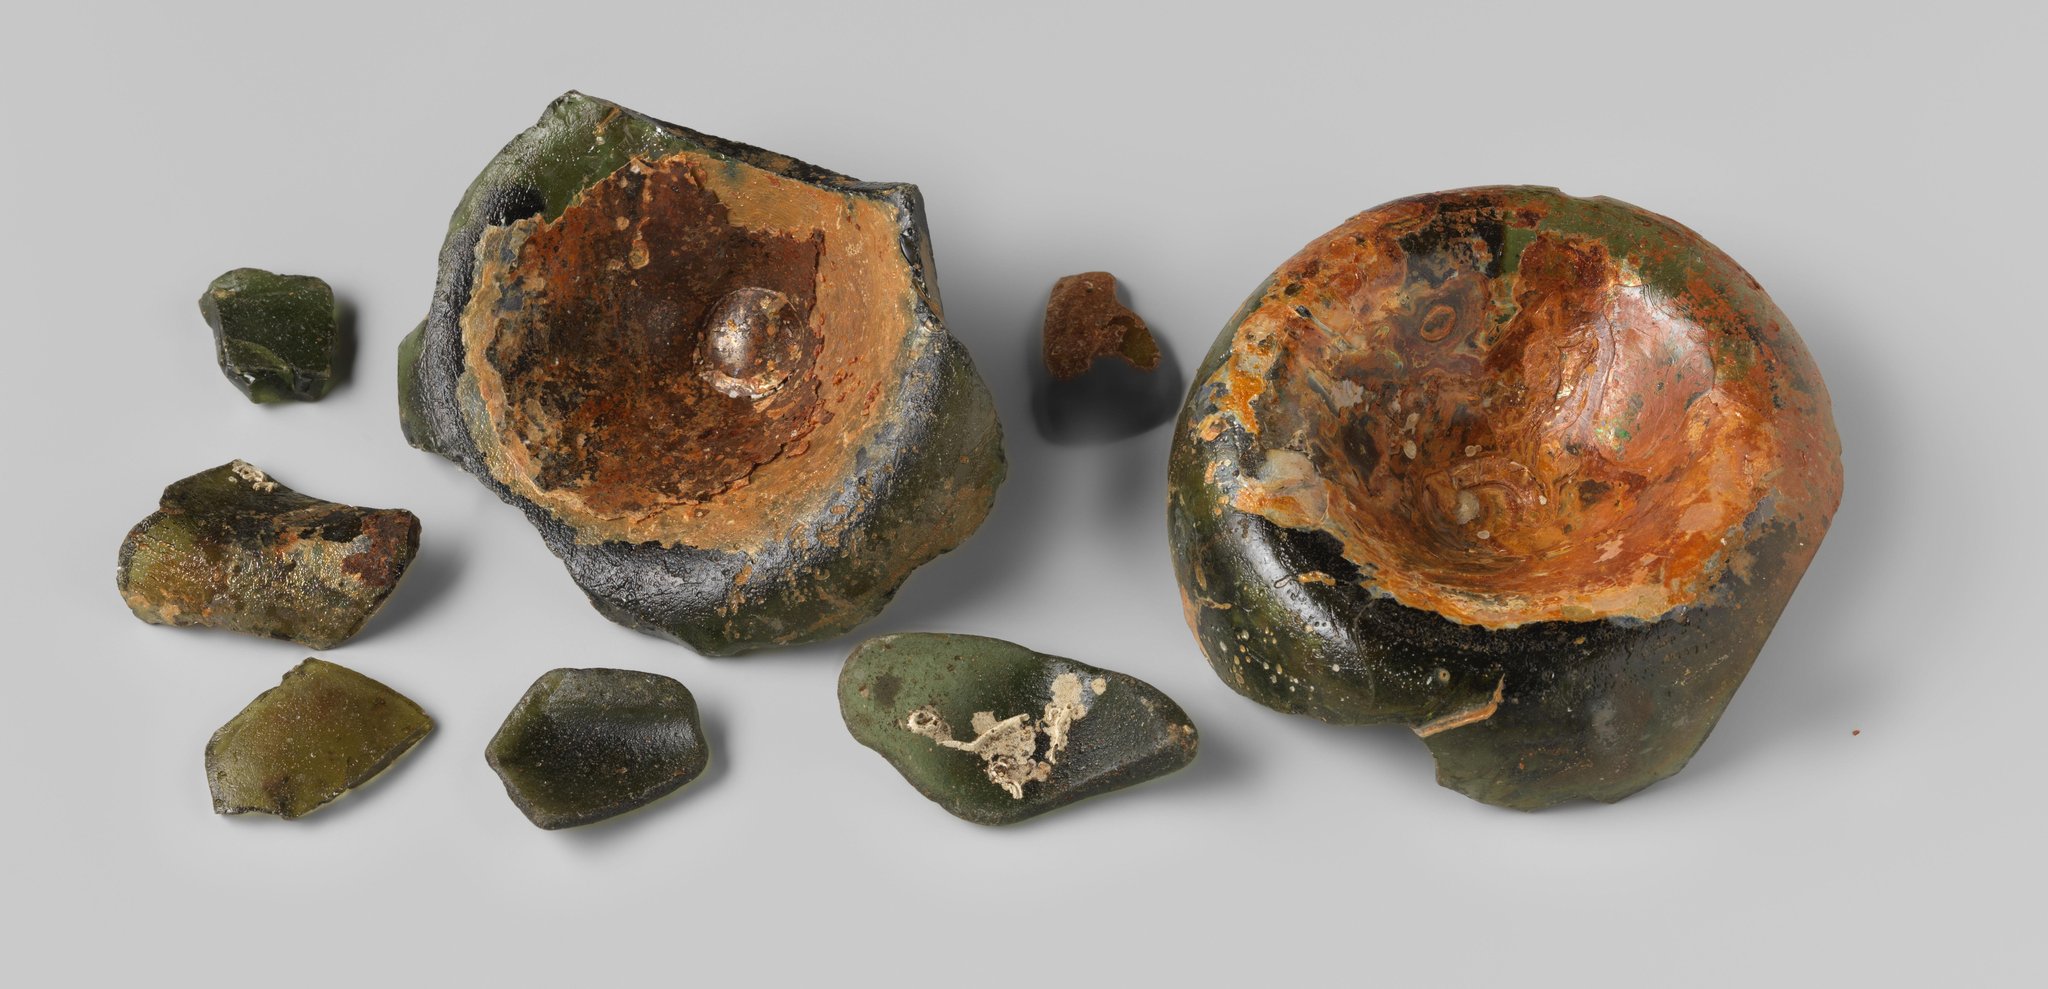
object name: wine bottle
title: Scherven van wijnflessen uit het wrak van de Oostindiëvaarder Hollandia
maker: Anonymous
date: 1700-1743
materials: glass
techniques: green glass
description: Scherven van wijnflessen, waaronder twee grote bodemfragmenten.